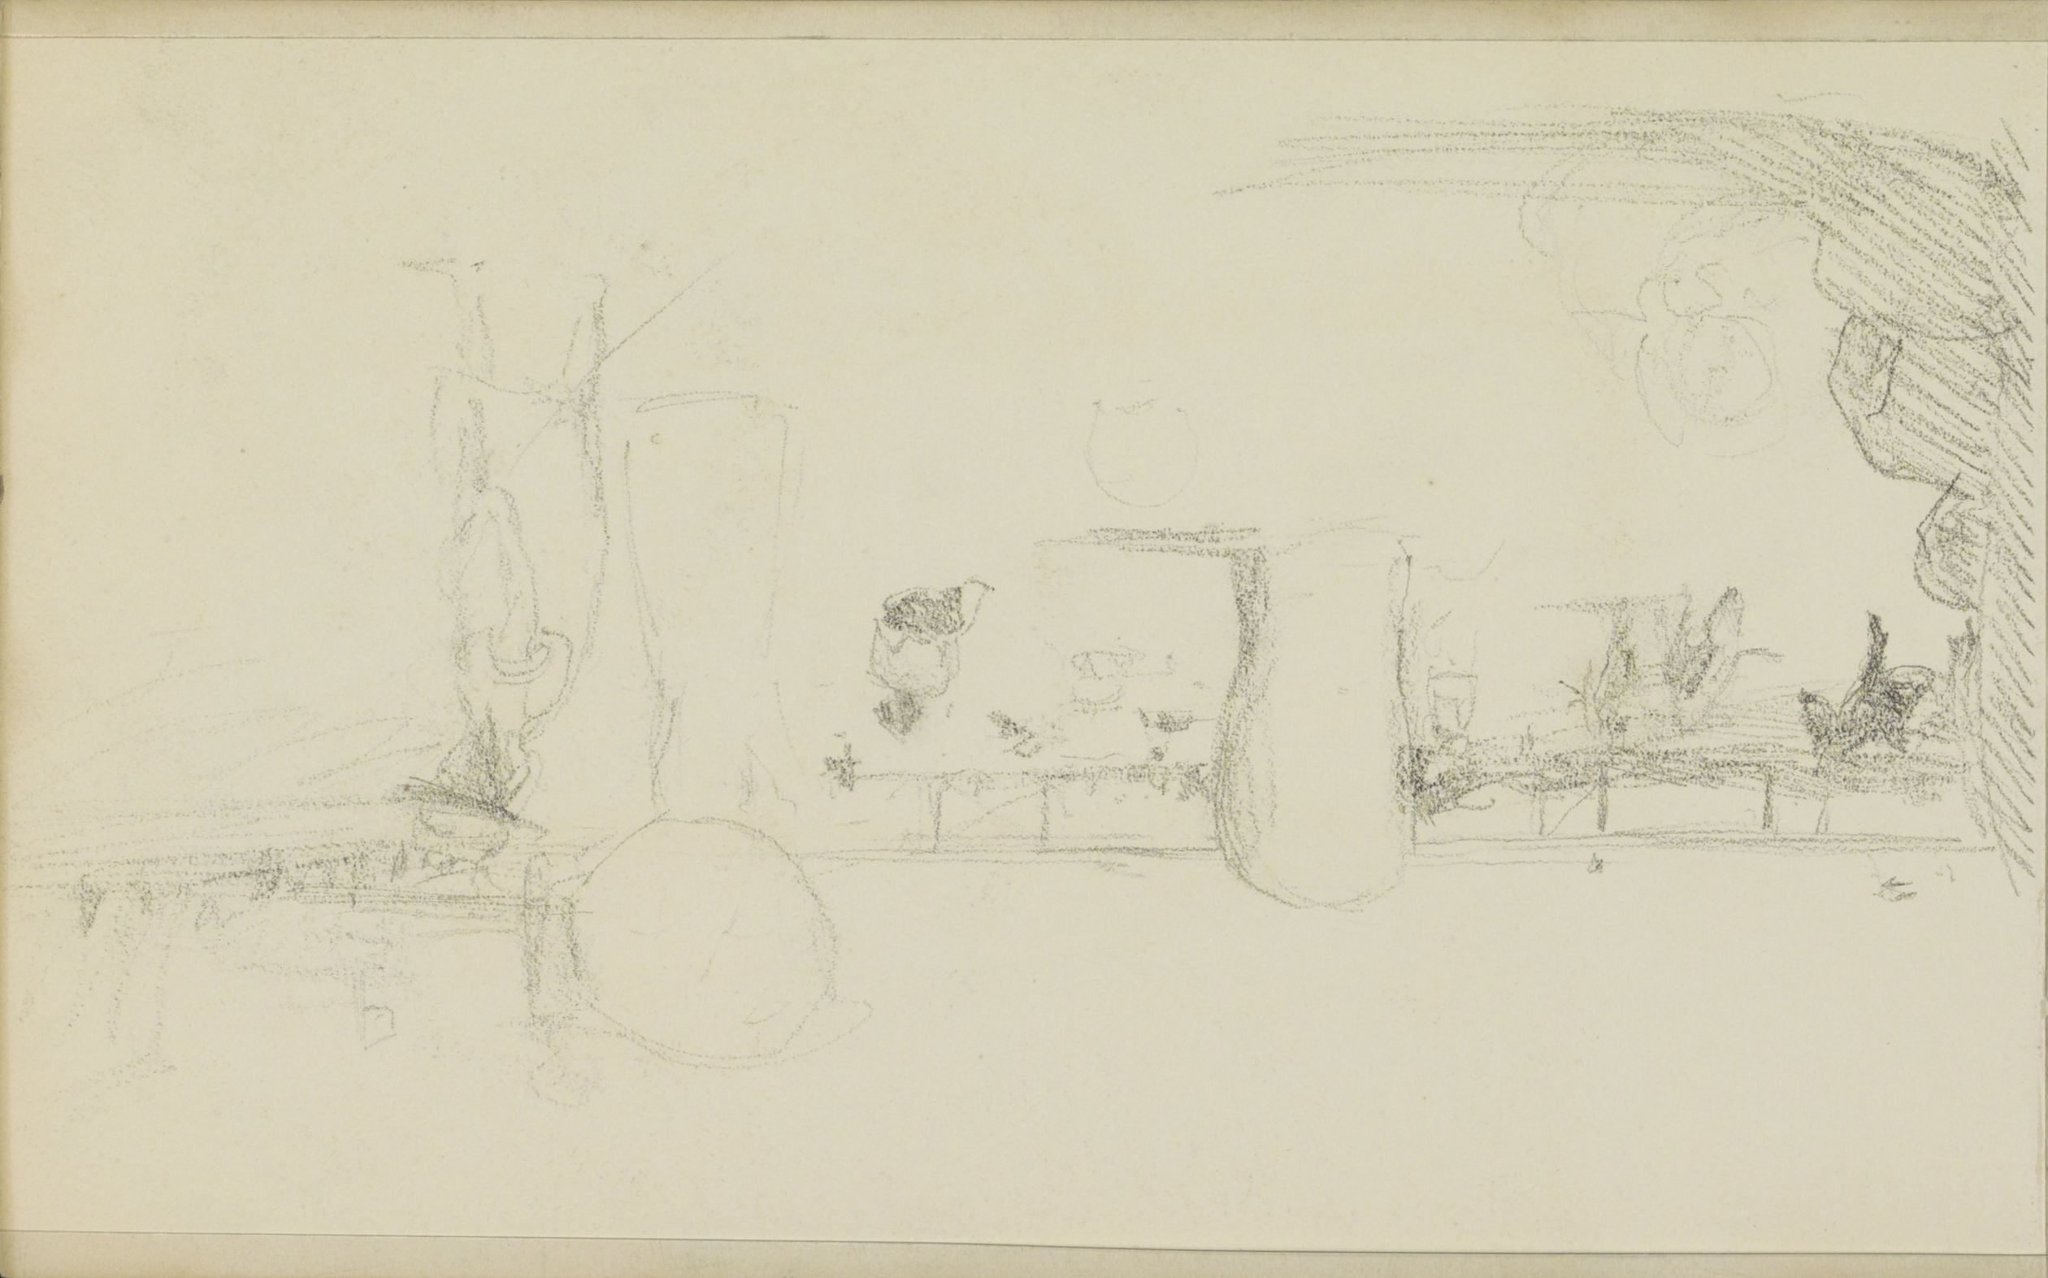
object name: sketchbook leaf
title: Strand met figuren, rieten strandstoelen en ezels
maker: a.a.l. de grammont-hubrecht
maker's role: draughtsman, painter, print maker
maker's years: 1855-1913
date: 1892-1913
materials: chalk, paper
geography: scheveningen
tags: beach (as place of recreation), chair, parasol, sunshade, donkey-riding (on the beach)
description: Op de achtergrond een deel van een pier, vermoedelijk de pier van Scheveningen die in 1901 werd geopend. Blad 22 verso uit een schetsboek met 31 bladen.